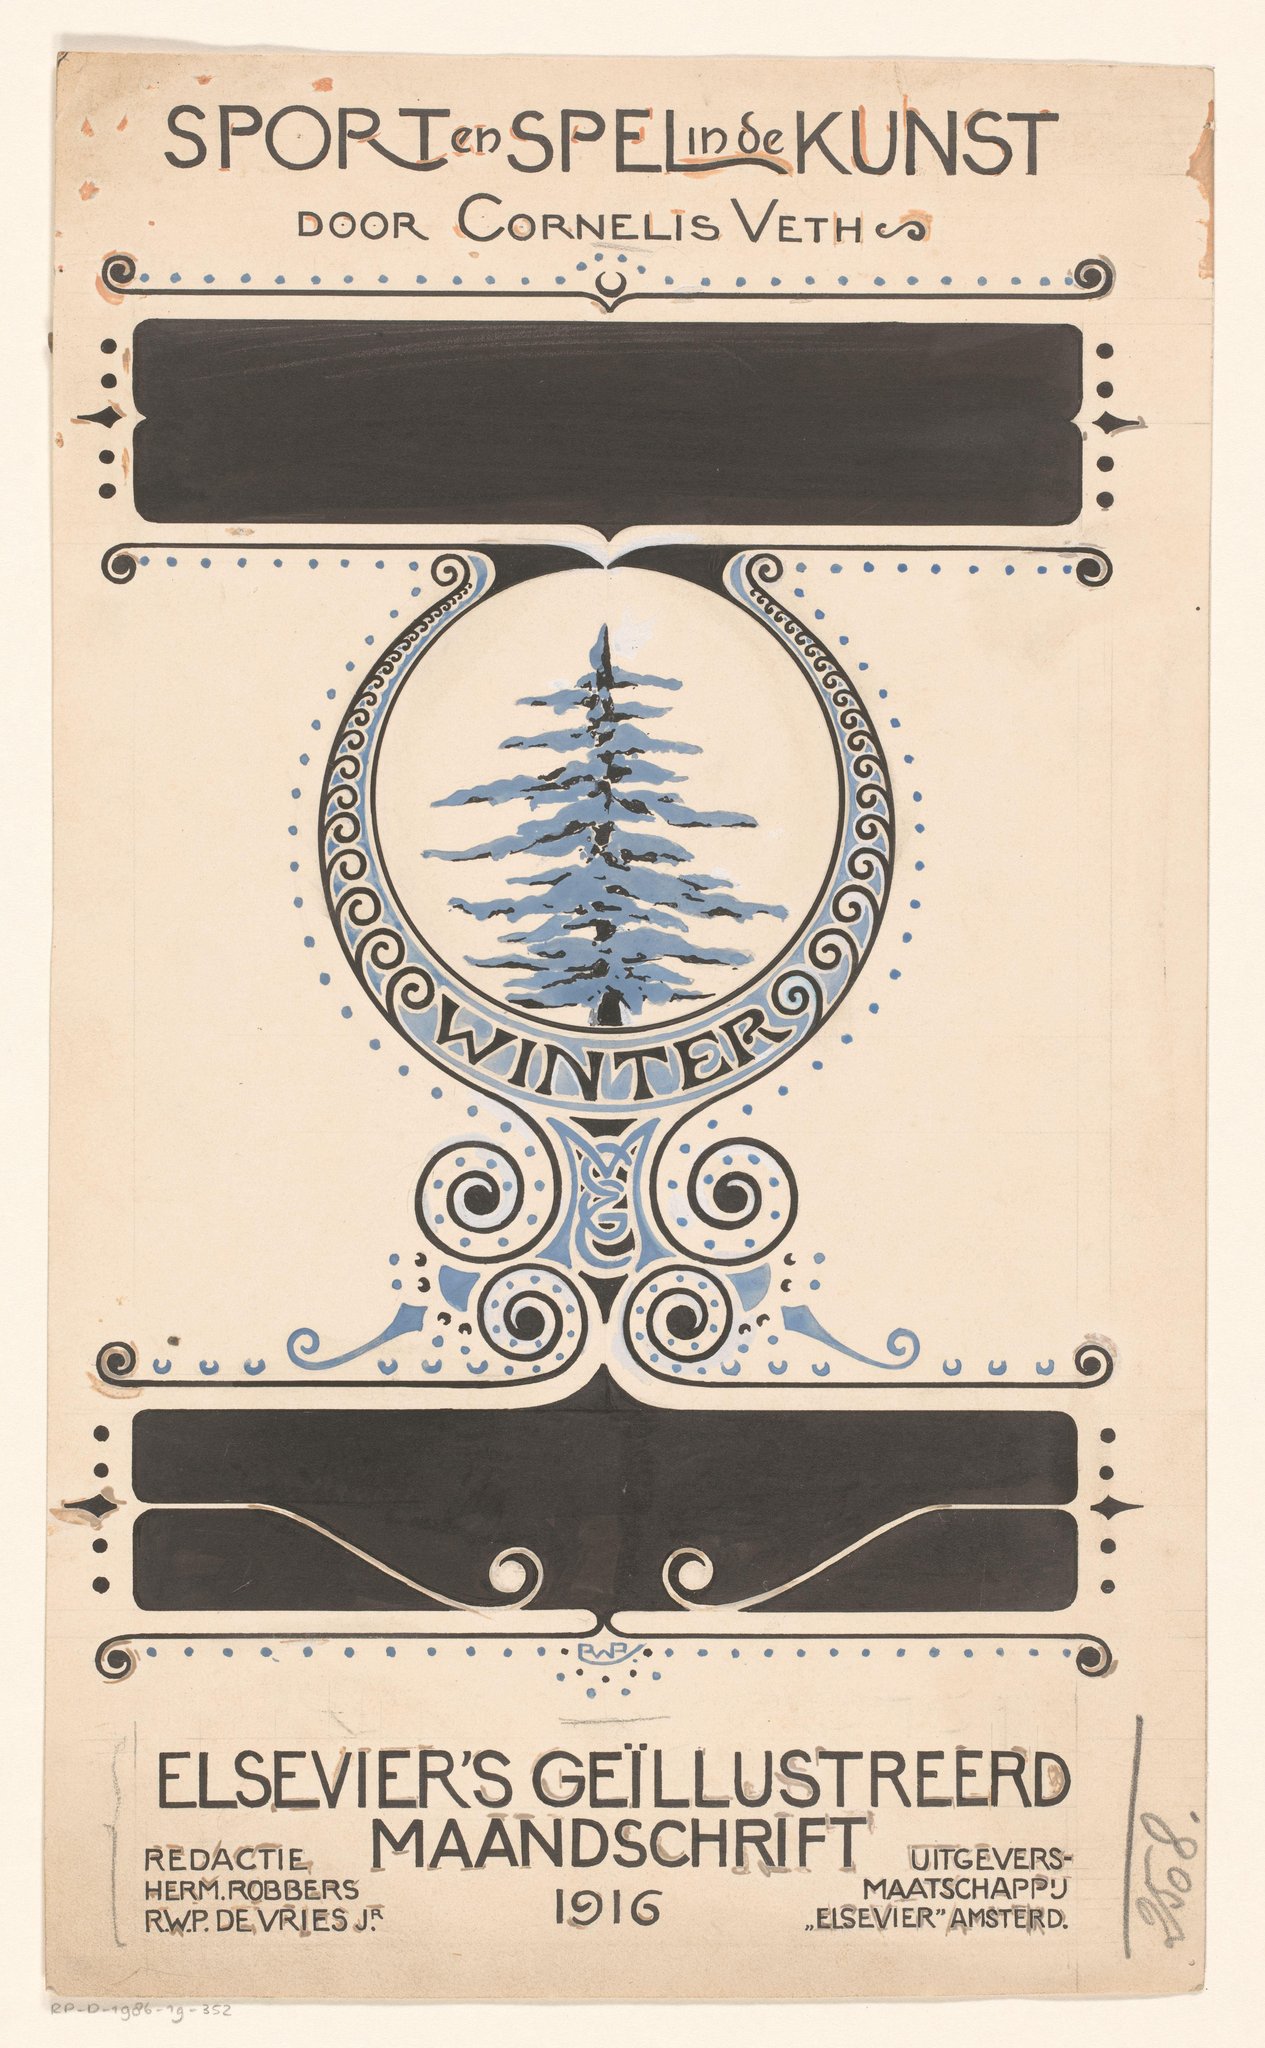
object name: drawing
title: Omslagontwerp voor: Cornelis Veth, Sport en spel in de kunst (Winter), 1916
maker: reinier willem petrus de vries (1874-1953)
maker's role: draughtsman, print maker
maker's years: 1874-1953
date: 1916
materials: paint, ink, paper, pencil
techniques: brush, pen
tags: snow, trees: pine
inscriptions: collector's mark: ‘R:MVS.’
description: Ontwerp met een besneeuwde dennenboom in een cirkel en ornamenten.